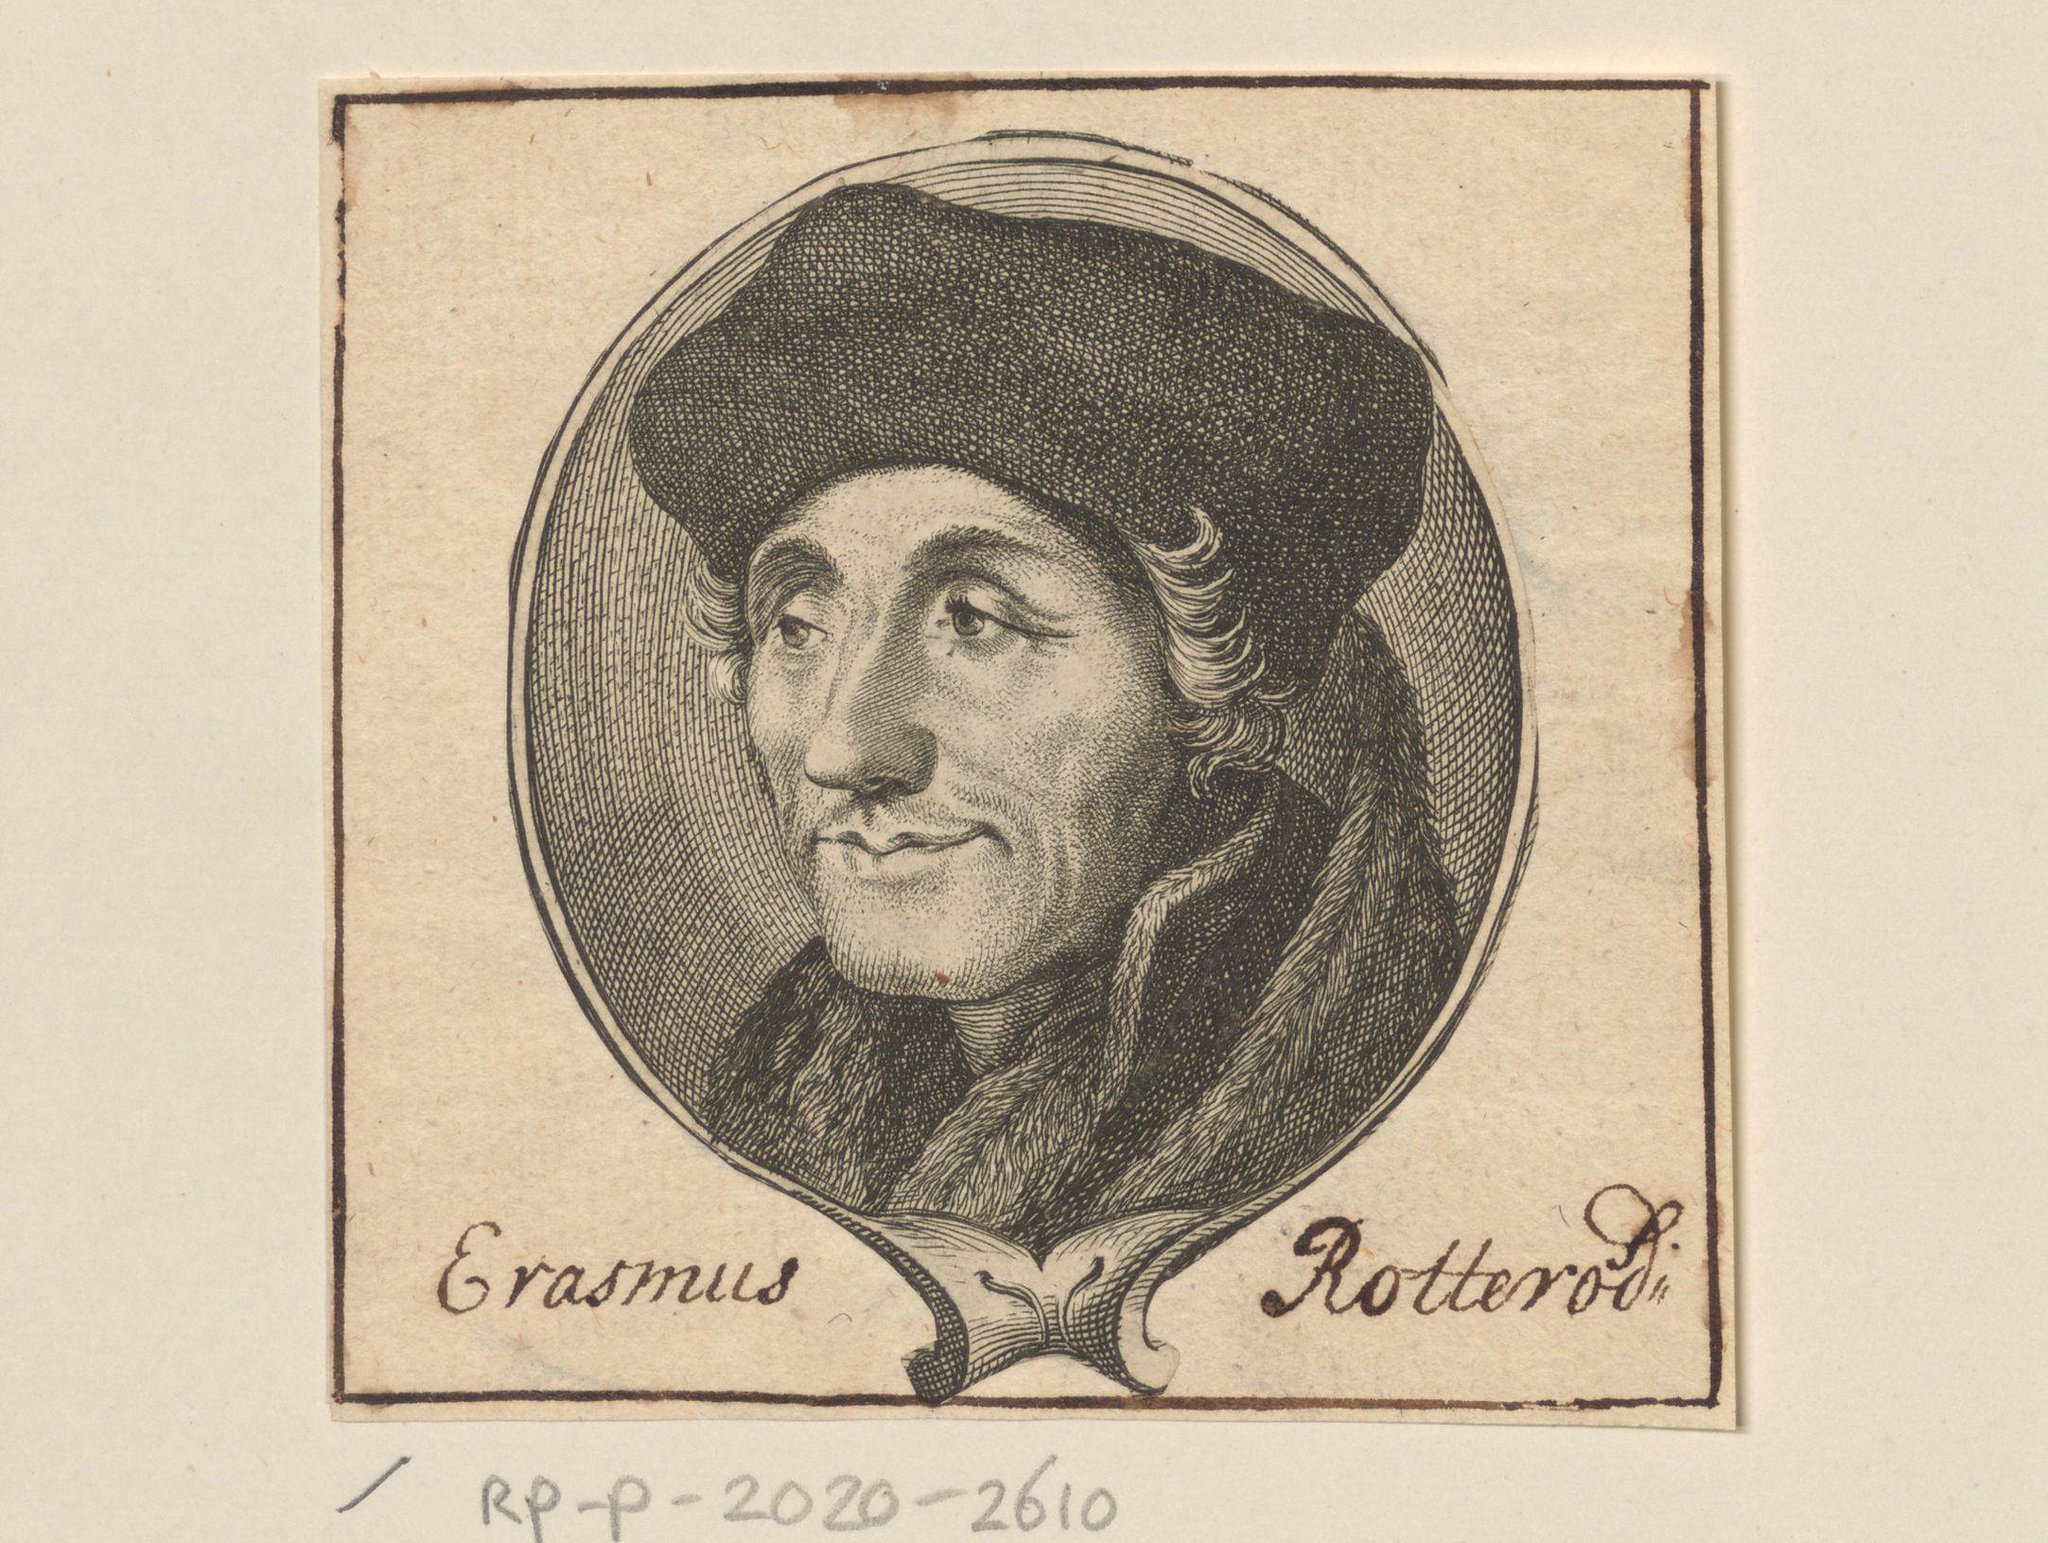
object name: print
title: Portret van Desiderius Erasmus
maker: Anonymous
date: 1650-1750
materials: paper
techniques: engraving, etching, snipping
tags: rotterdam, desiderius erasmus, historical persons, scholar, philosopher (+ portrait of scholar, scientist)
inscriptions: inscription: ‘Erasmus Rotterodii’